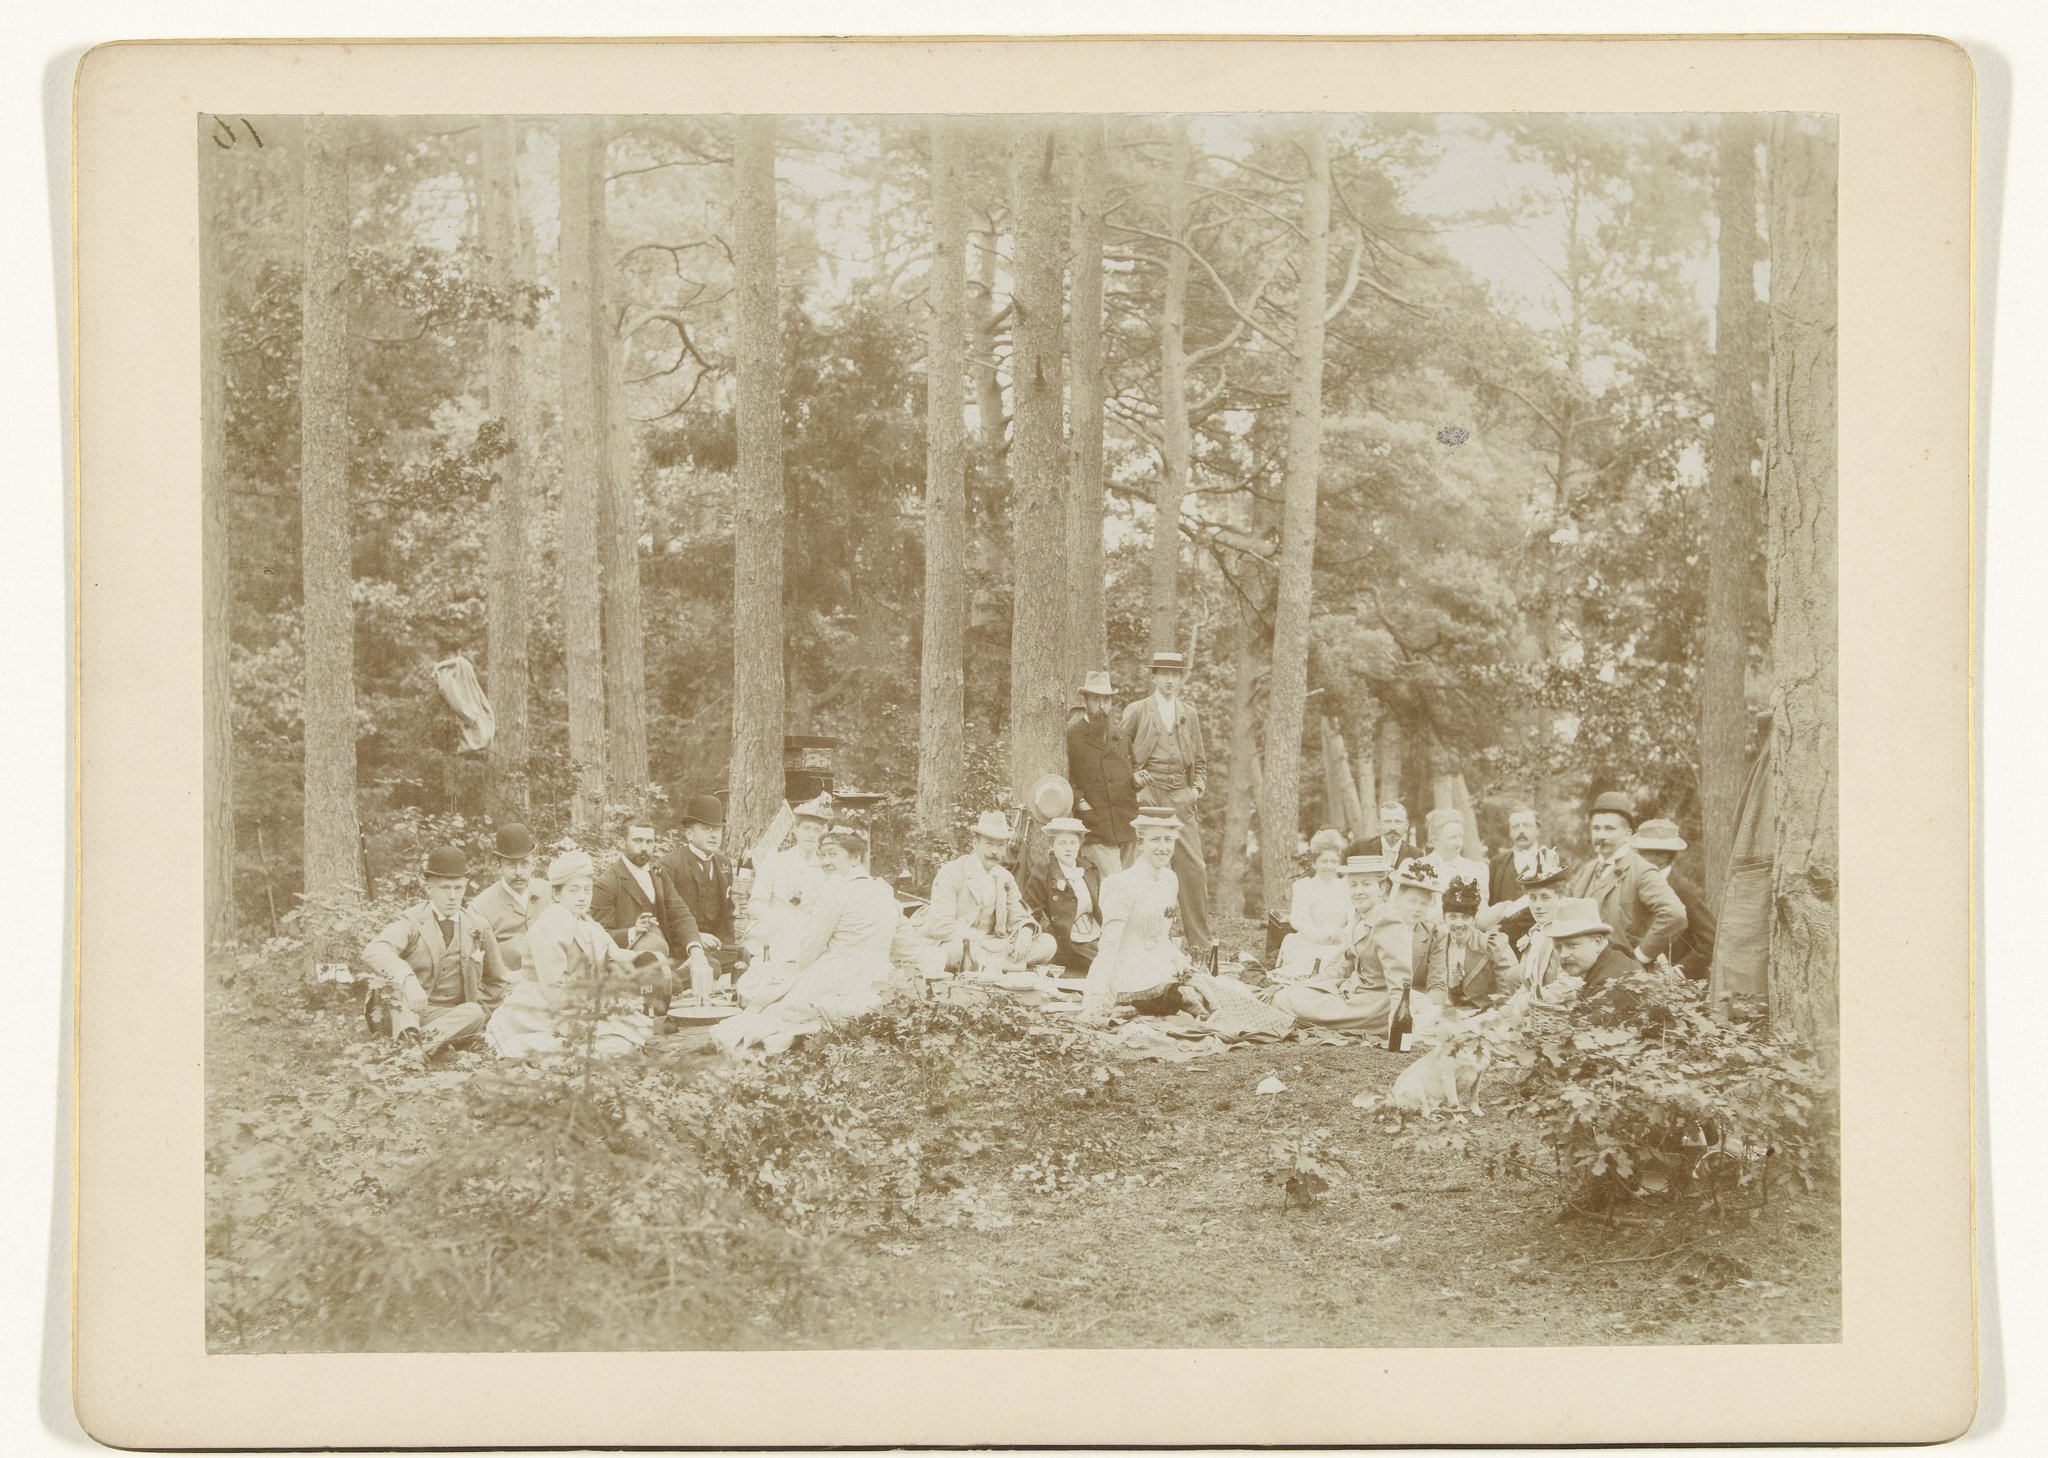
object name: photograph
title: Groepsportret van 23 mannen en vrouwen tijdens een picknick in een bos, met o.a. Henry Pauw van Wieldrecht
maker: henry pauw van wieldrecht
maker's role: fotograaf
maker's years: 1863-1912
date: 1892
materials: cardboard, photographic support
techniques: gelatin silver print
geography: netherlands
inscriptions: annotation: ‘No. 550. 1892.’